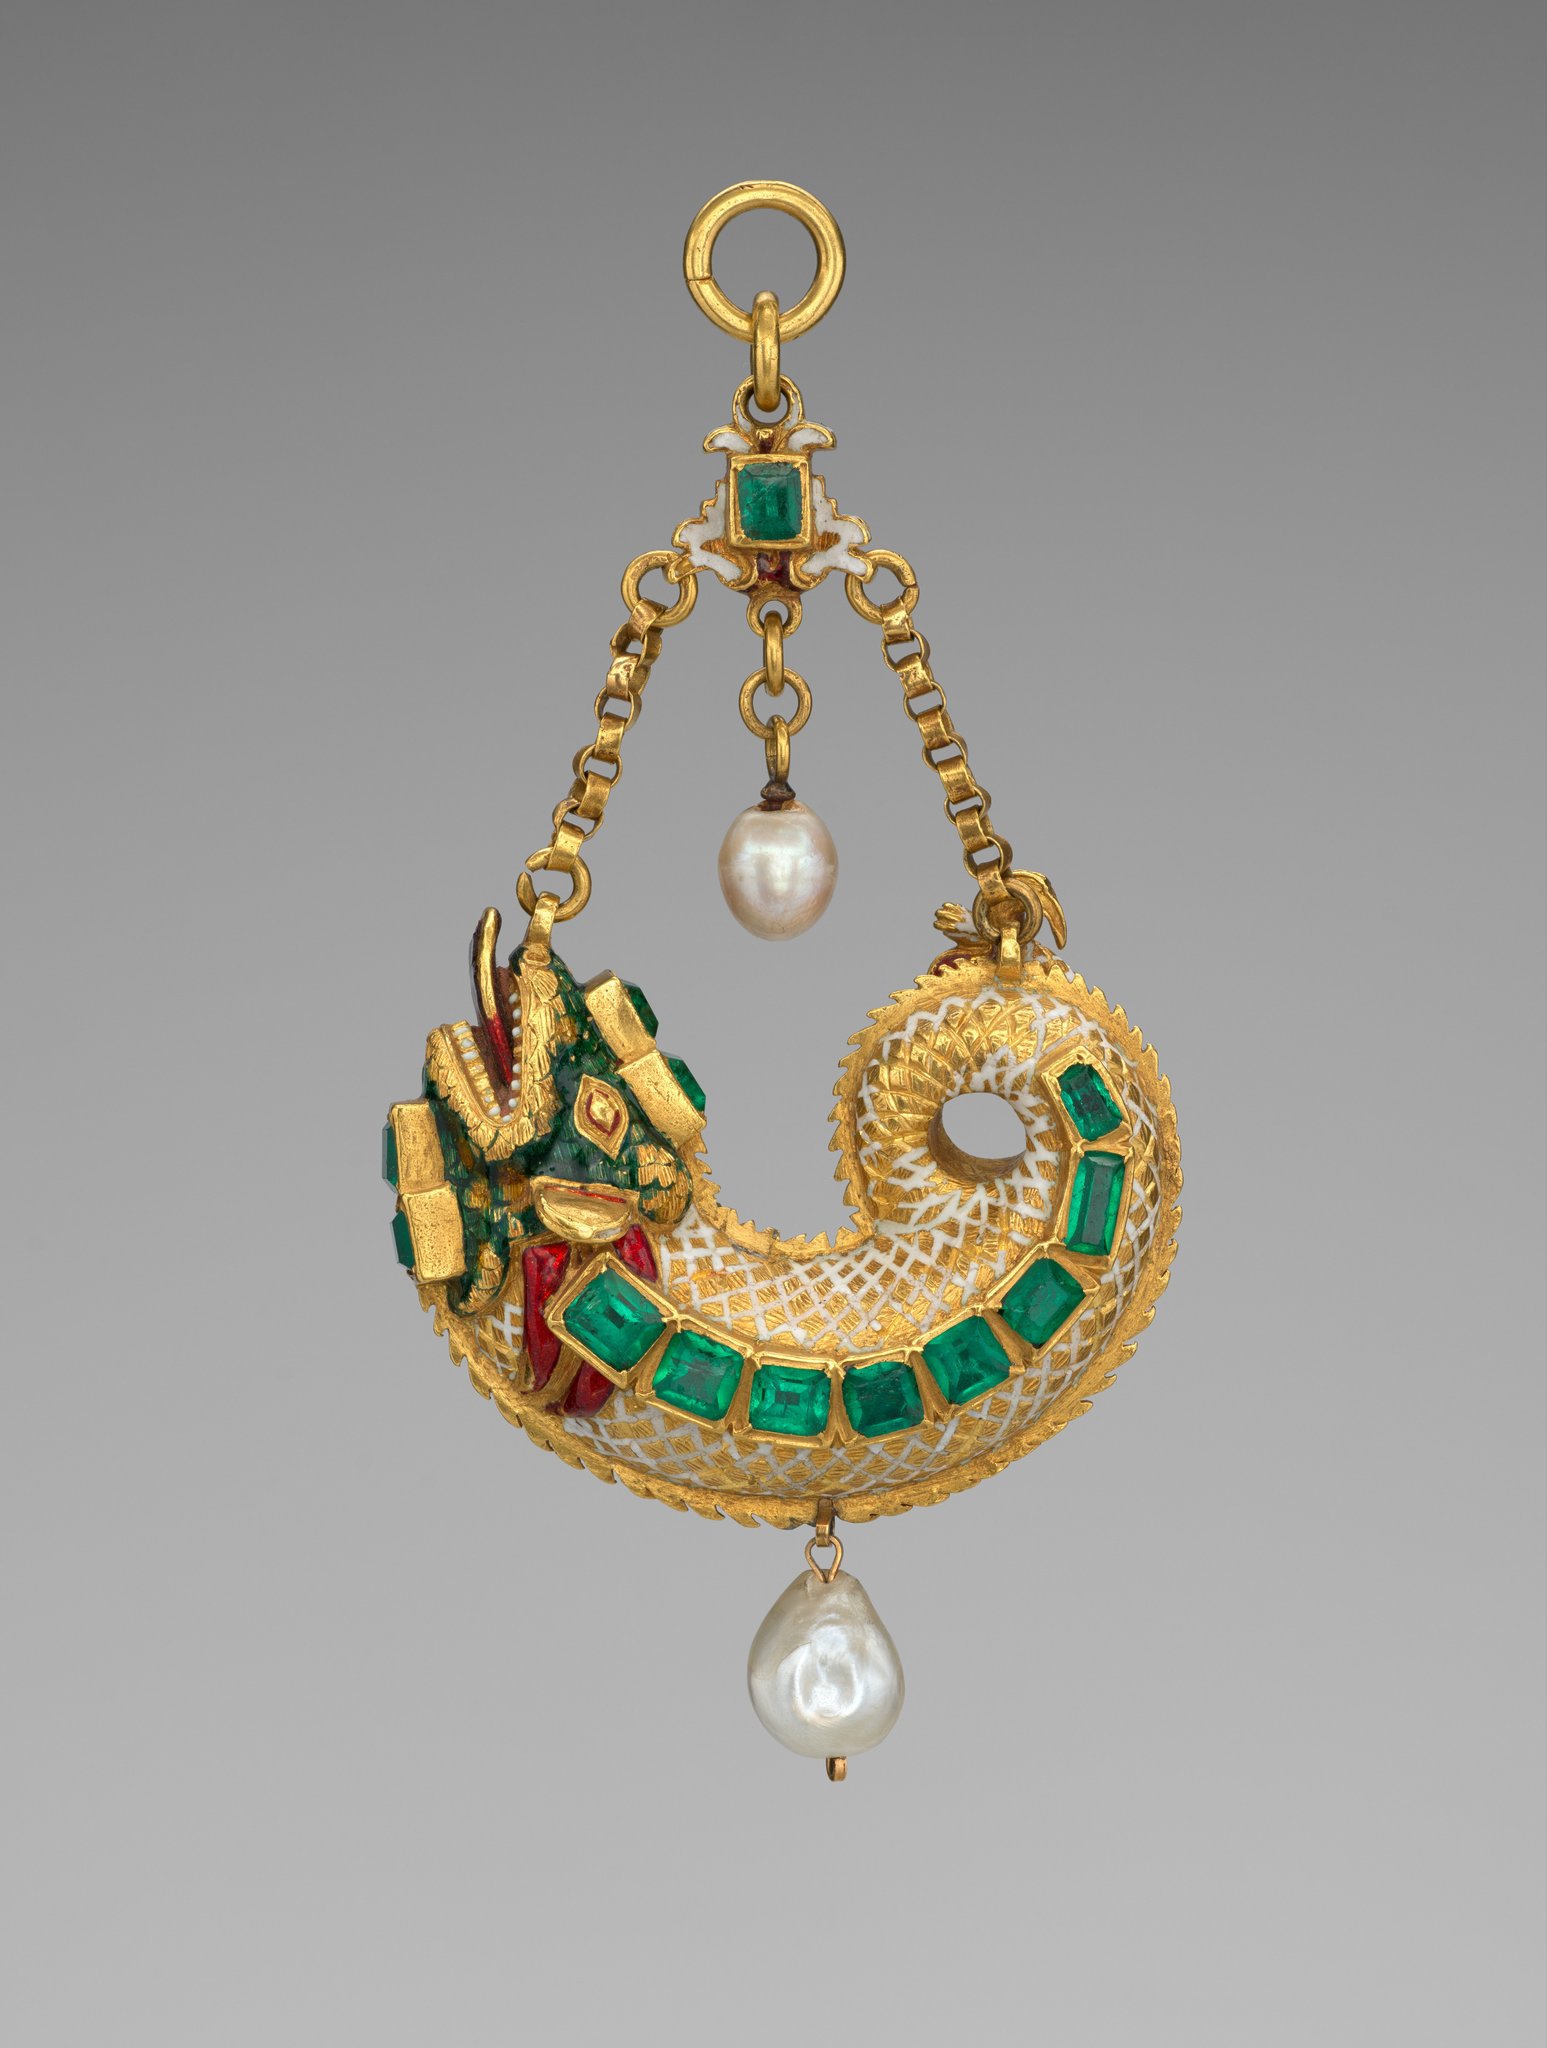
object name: pendant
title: Pendant in the form of a fish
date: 1567-1633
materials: gemstone, enamel, gold, pearl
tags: fish